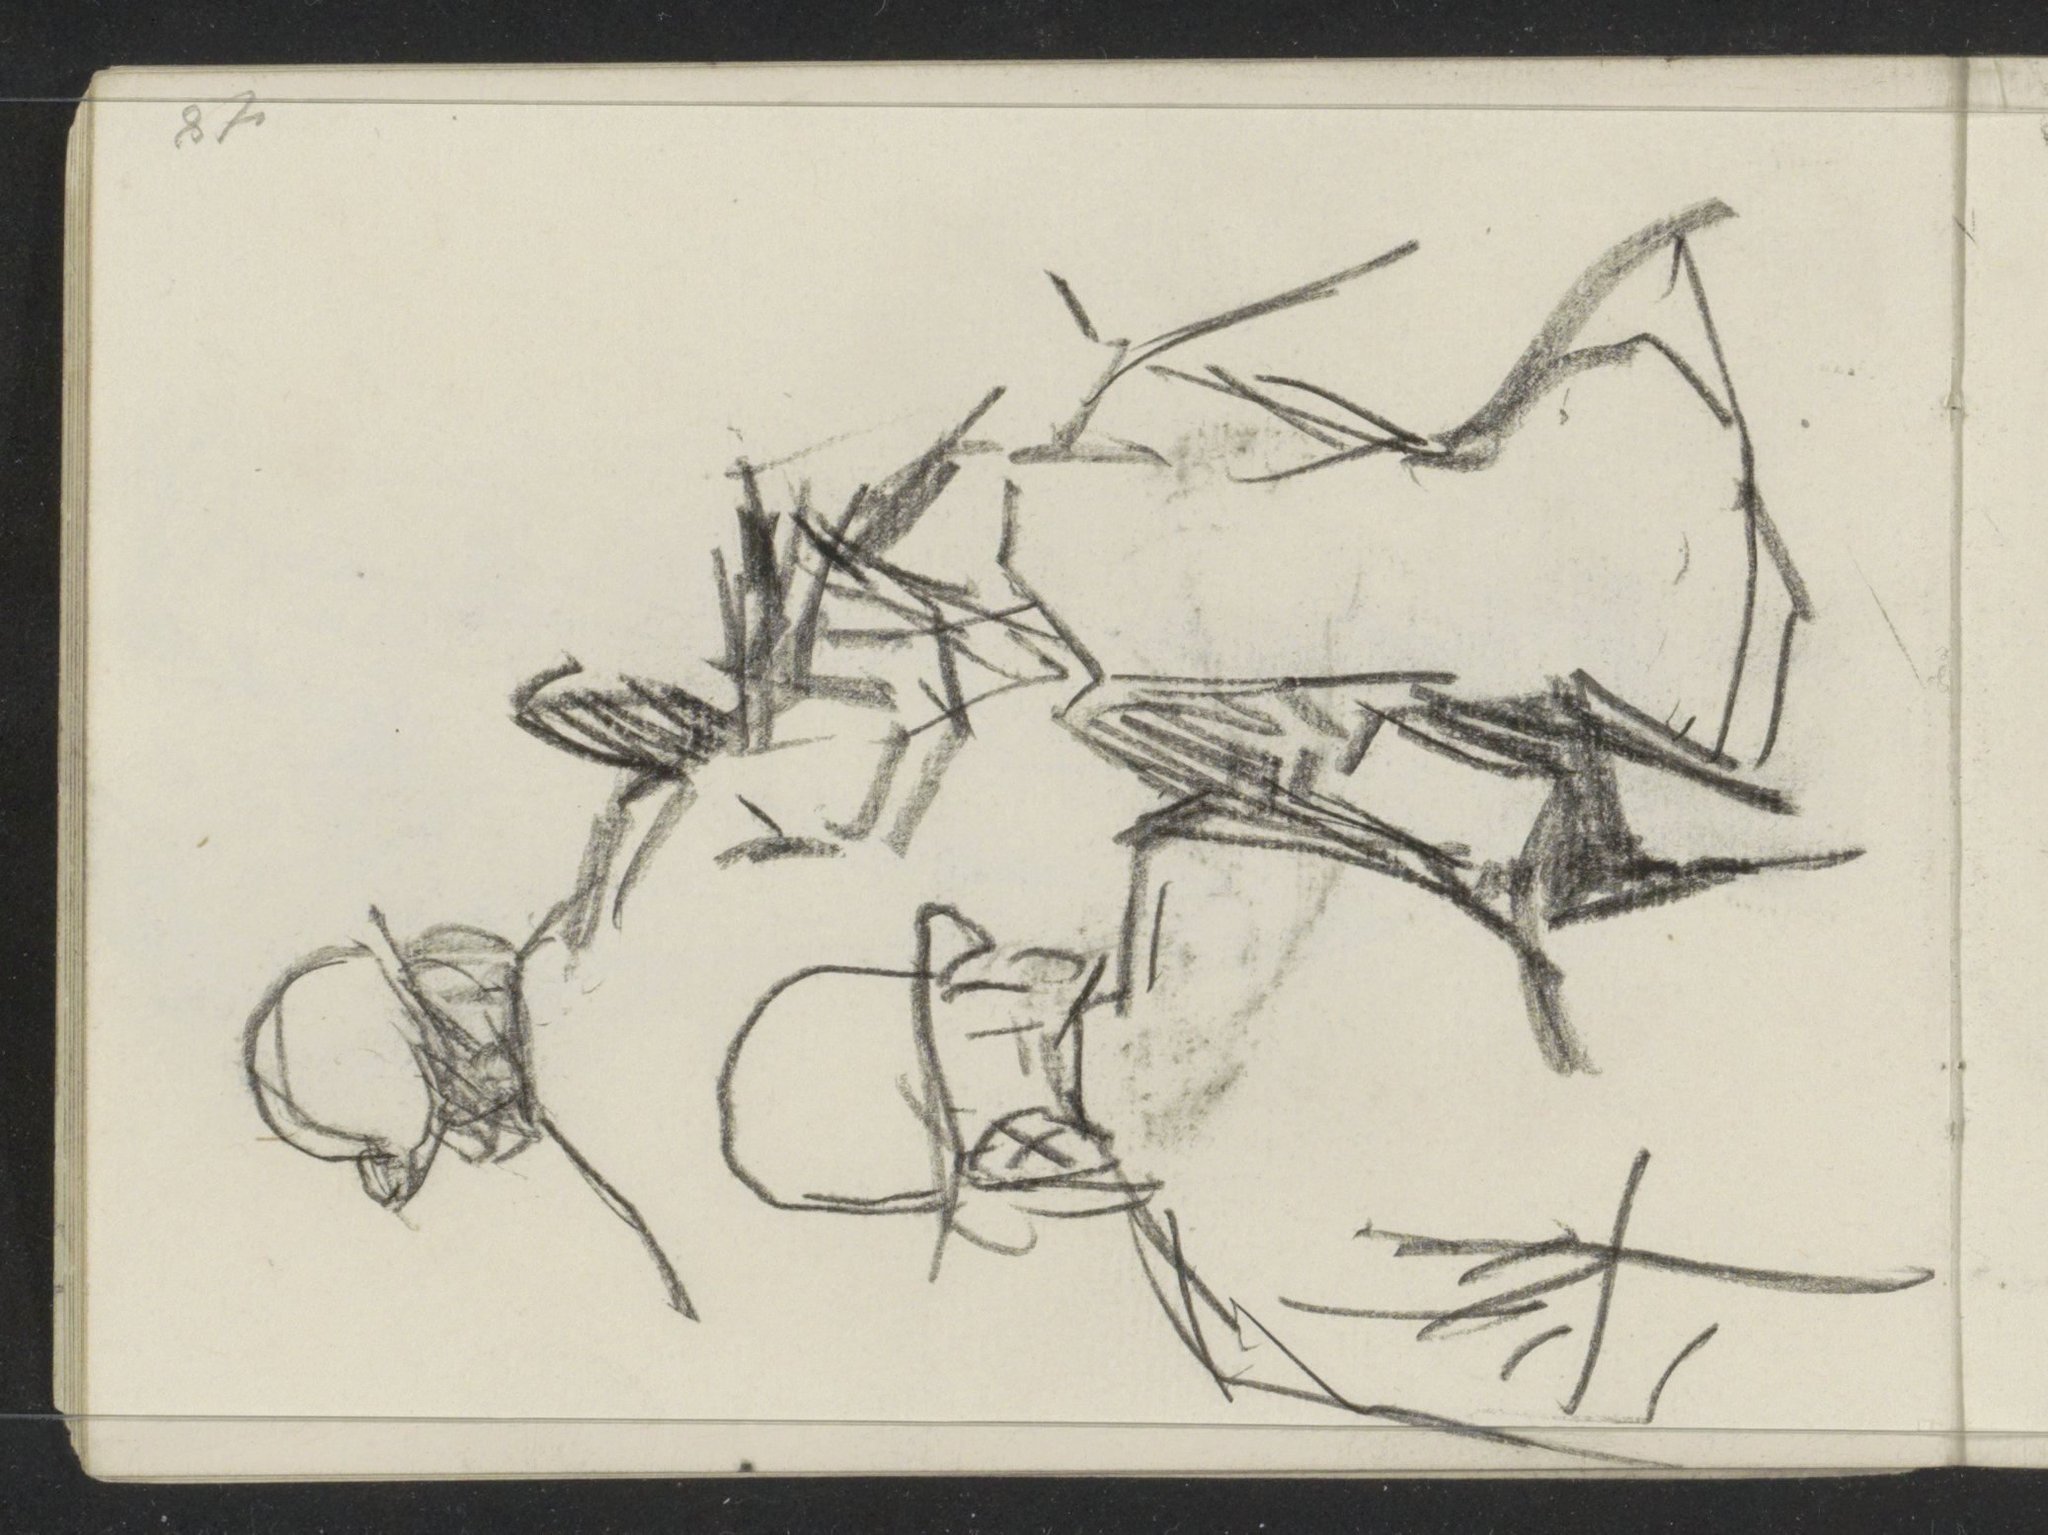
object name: sketchbook leaf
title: Man met bolhoed en een gearmd paar, op de rug gezien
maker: isaac israels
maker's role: draughtsman, painter, print maker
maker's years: 1865-1934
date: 1886-1934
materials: chalk, paper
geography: amsterdam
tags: head-gear: bowler hat, adult man (+ back view), walking arm in arm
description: Blad 11 verso uit schetsboek LXIV met 29 bladen.